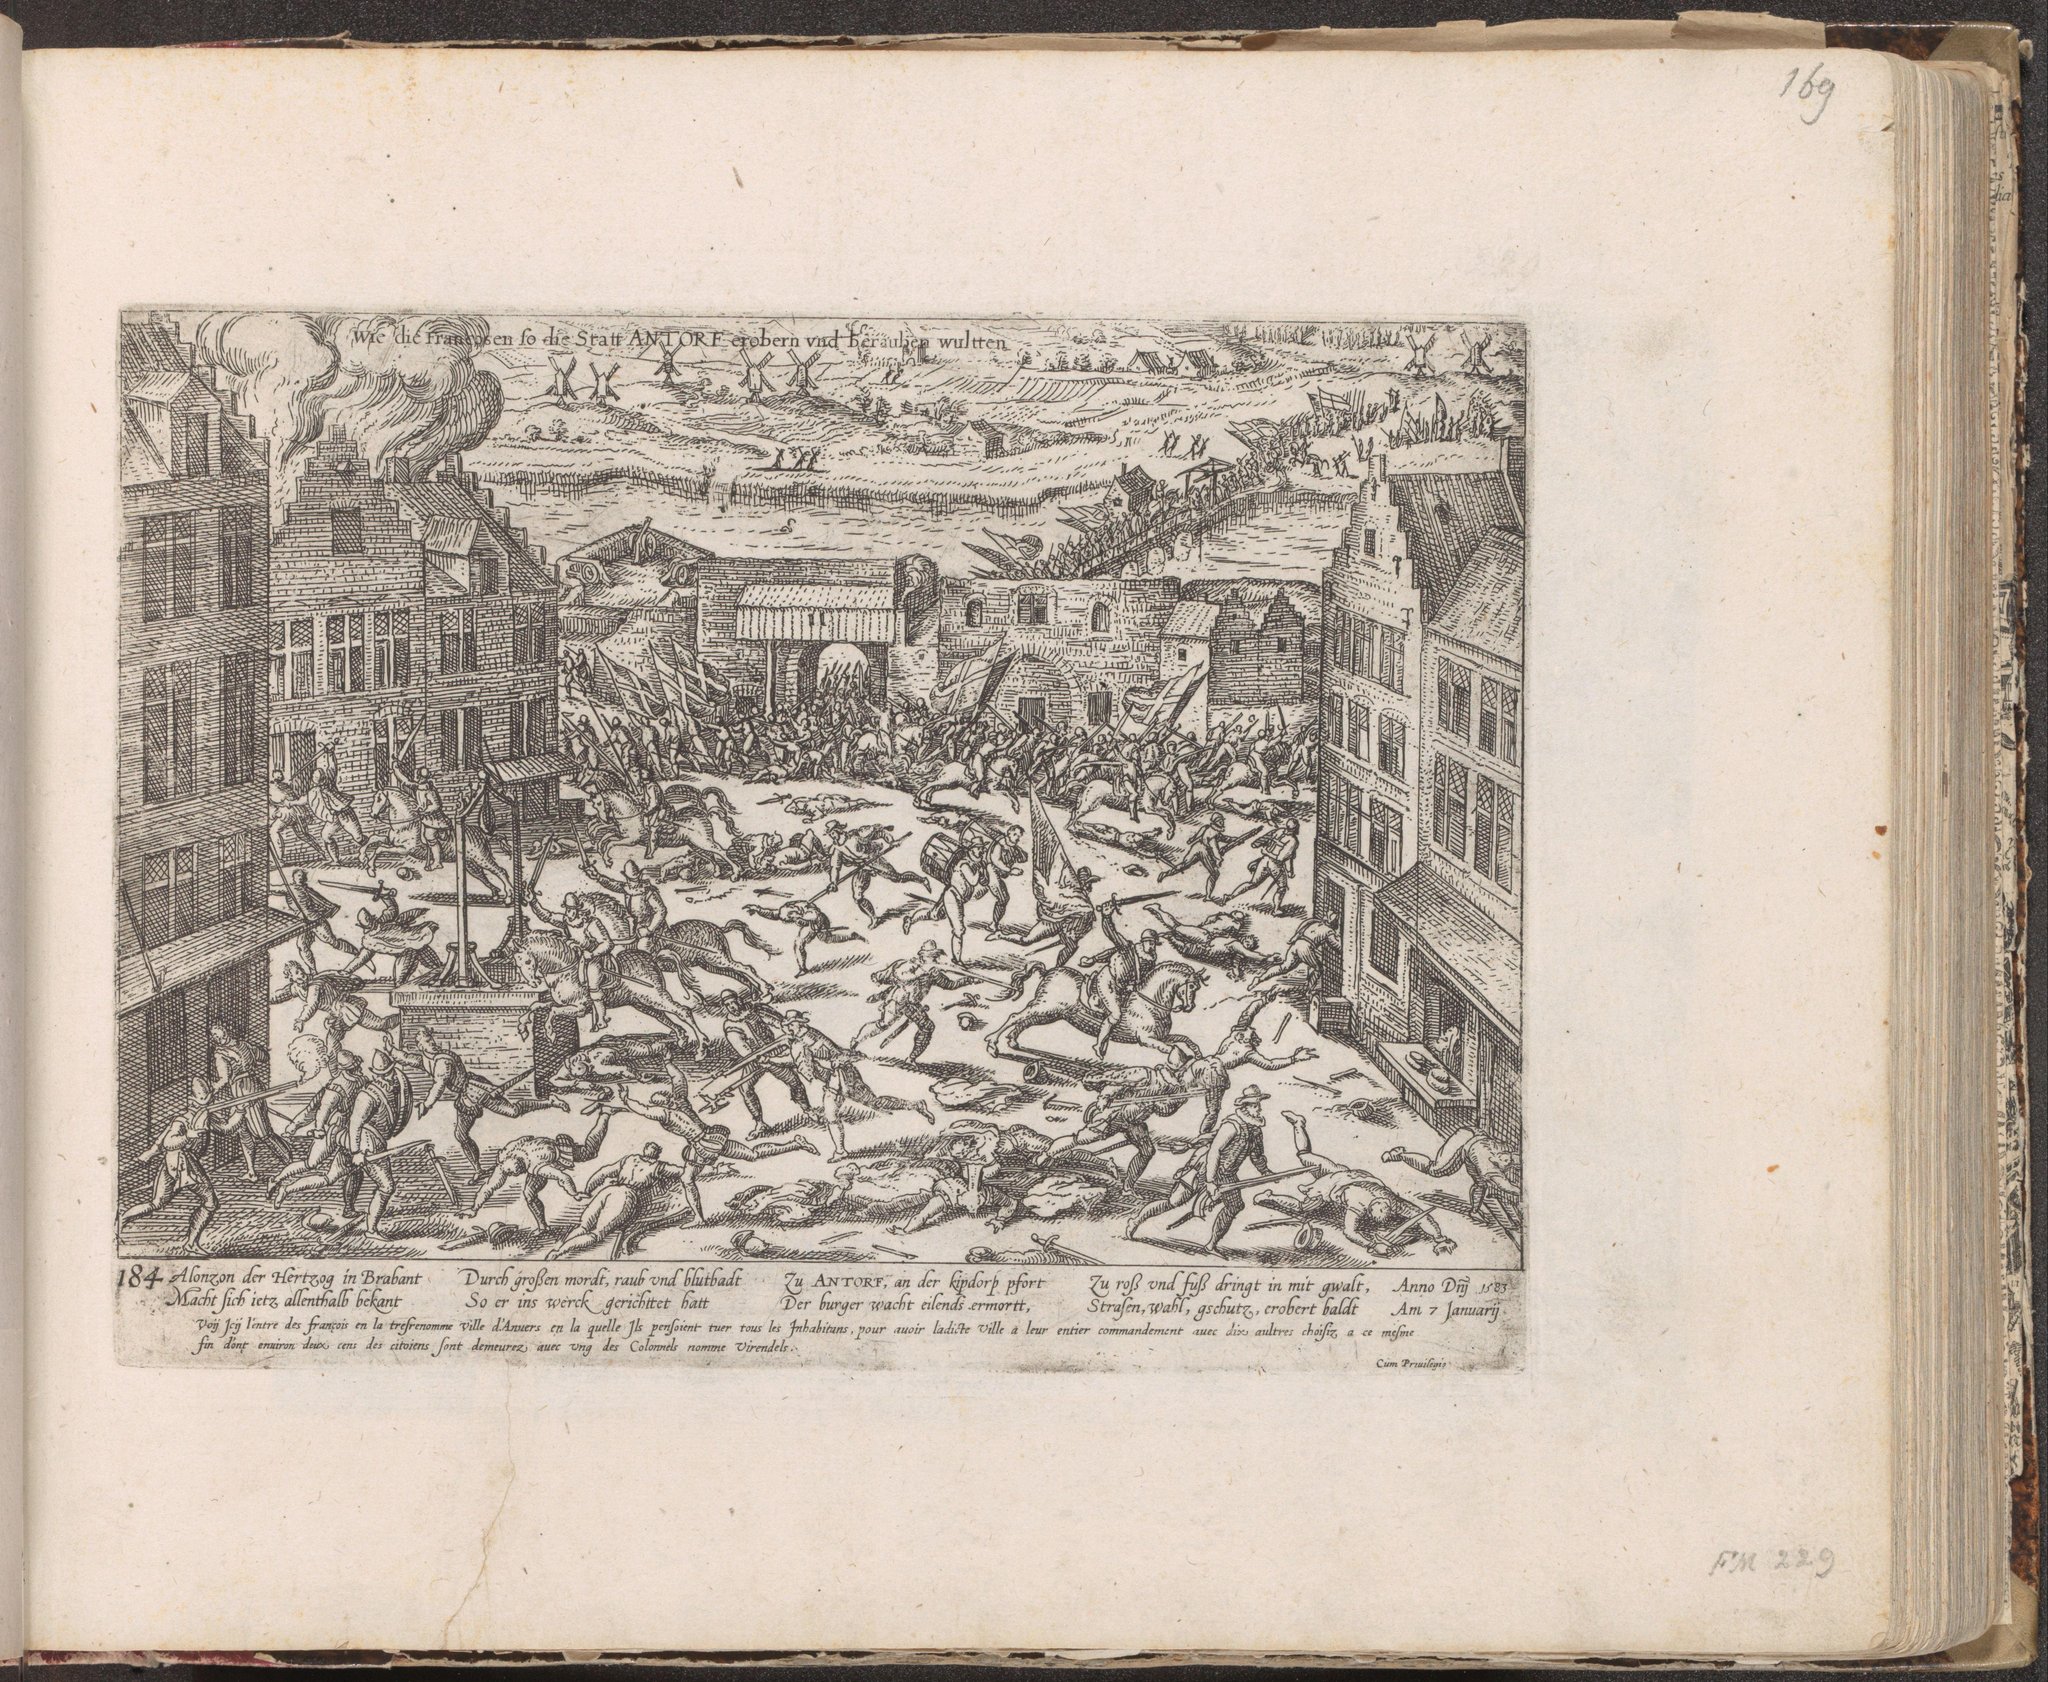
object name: print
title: Wie die Francosen so die Statt Antorf erobern und berauben wultten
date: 1583-1585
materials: paper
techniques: etching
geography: cologne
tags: françois-hercule de valois (hertog van anjou), massacre ~ war, antwerp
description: De Franse Furie te Antwerpen, 17 januari 1583. Moord en plundering door Franse soldaten in de straten van Antwerpen in een poging de stad te veroveren voor de hertog van Anjou. Met onderschrift van 8 regels in het Duits en 2 regels in het Frans. Linksonder genummerd: 184. De prent maakt deel uit van een album.